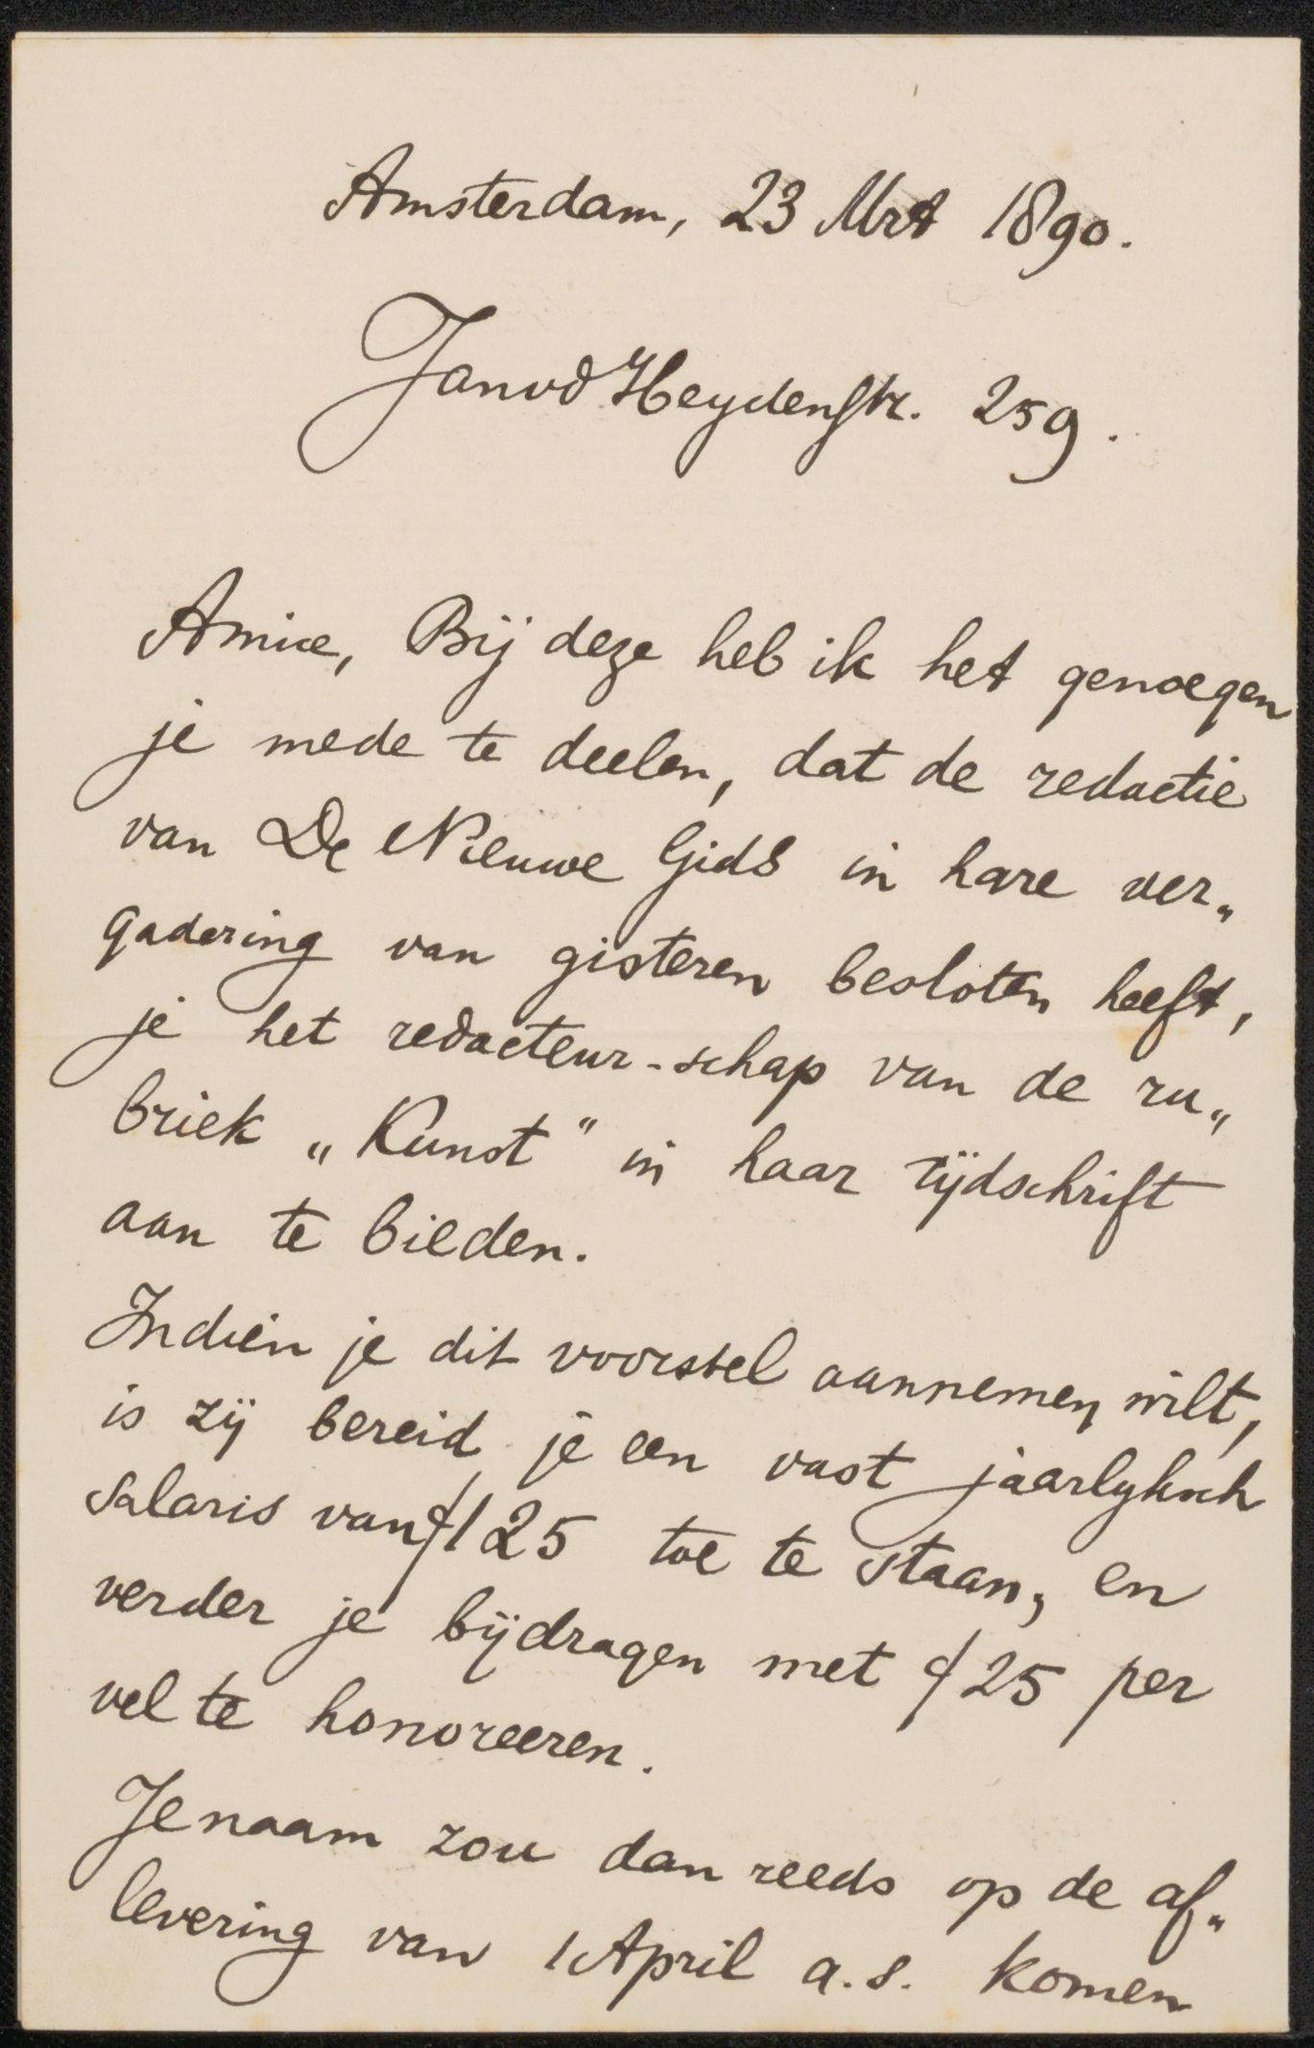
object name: letter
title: Brief aan Jan Veth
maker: willem kloos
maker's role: dichter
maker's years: 1859-1938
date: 1890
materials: ink, paper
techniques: pen, writing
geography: amsterdam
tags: painter, print maker, draughtsman, designer, jan veth, money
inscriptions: collector's mark: ‘RPK’, watermark